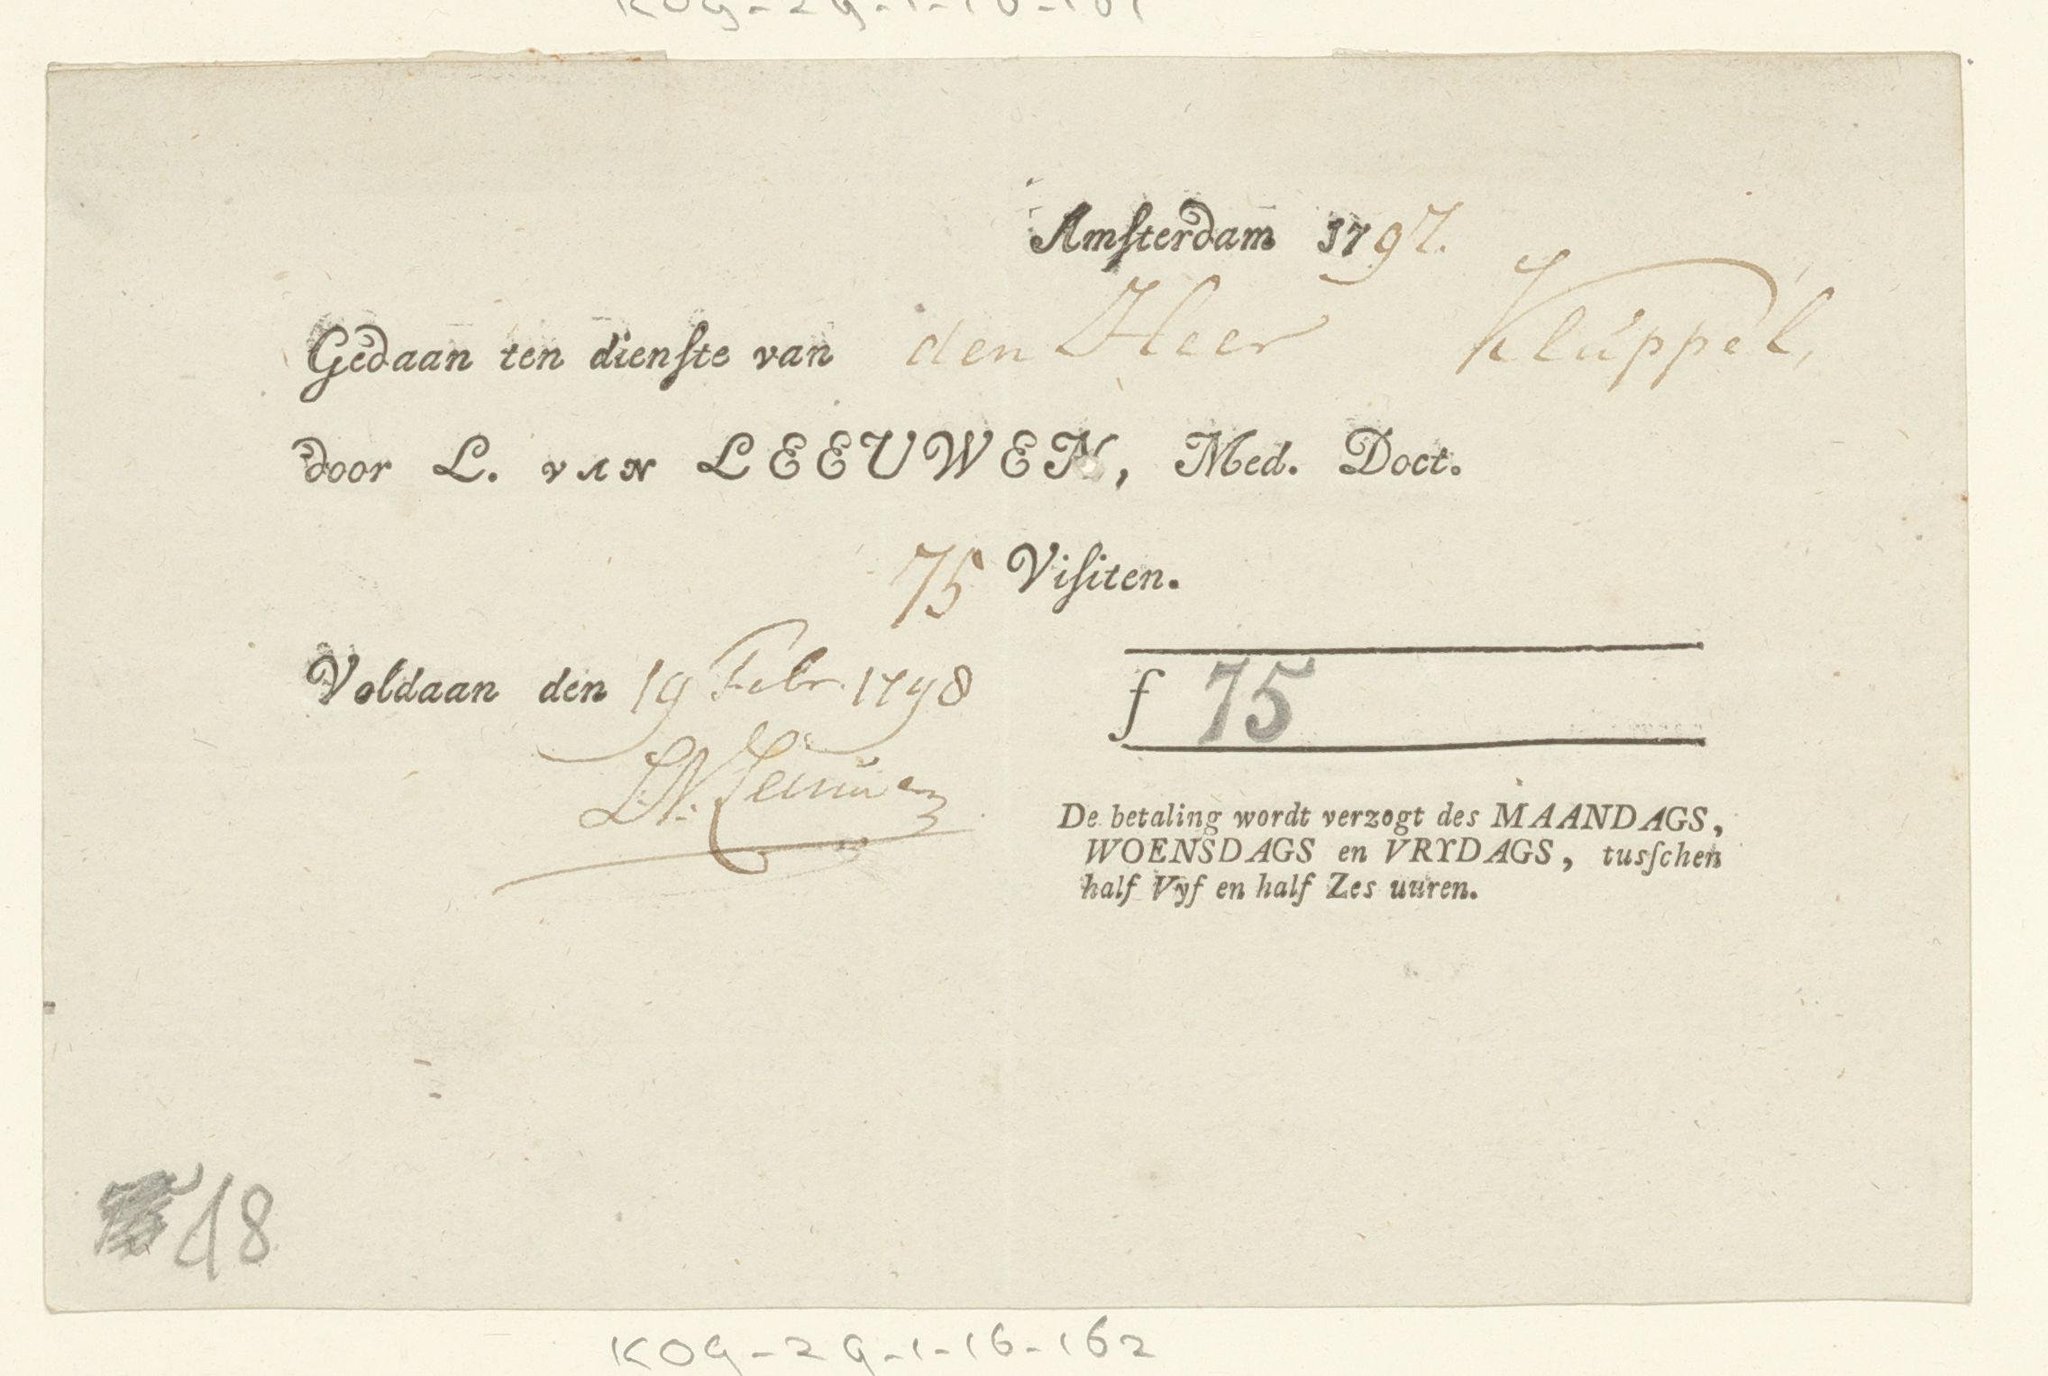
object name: account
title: Rekening van de geneesheer L. van Leeuwen, 1797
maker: Anonymous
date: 1797-1798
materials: ink, paper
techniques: letterpress printing, pen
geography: netherlands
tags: physician, doctor, medical examination, medical treatment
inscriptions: collector's mark: Lugt 1641, collector's mark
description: Rekening van de geneesheer L. van leeuwen, Amsterdam 1797, voldaan 19 februari 1798. Voorgedrukte kwitantie, ingevuld met pen. Onderwerpsrubrieken binnen de Atlas Zeden en Gewoonten: Onderwijs en Wetenschappen: Geneeskunde.